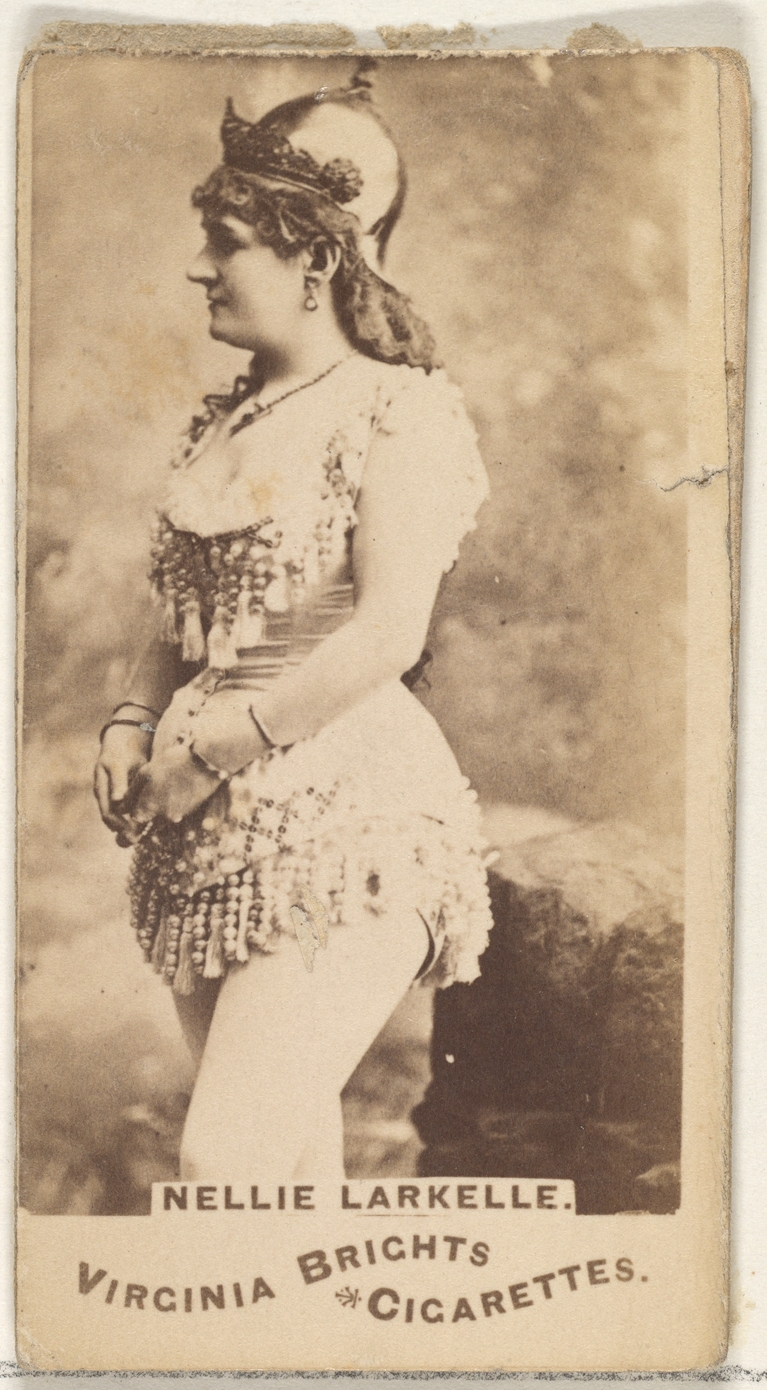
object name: photograph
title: Nellie Larkelle, from the Actors and Actresses series (N45, Type 1) for Virginia Brights Cigarettes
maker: allen & ginter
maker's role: publisher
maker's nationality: american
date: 1888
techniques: albumen silver print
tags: portraits,profiles,women,actresses